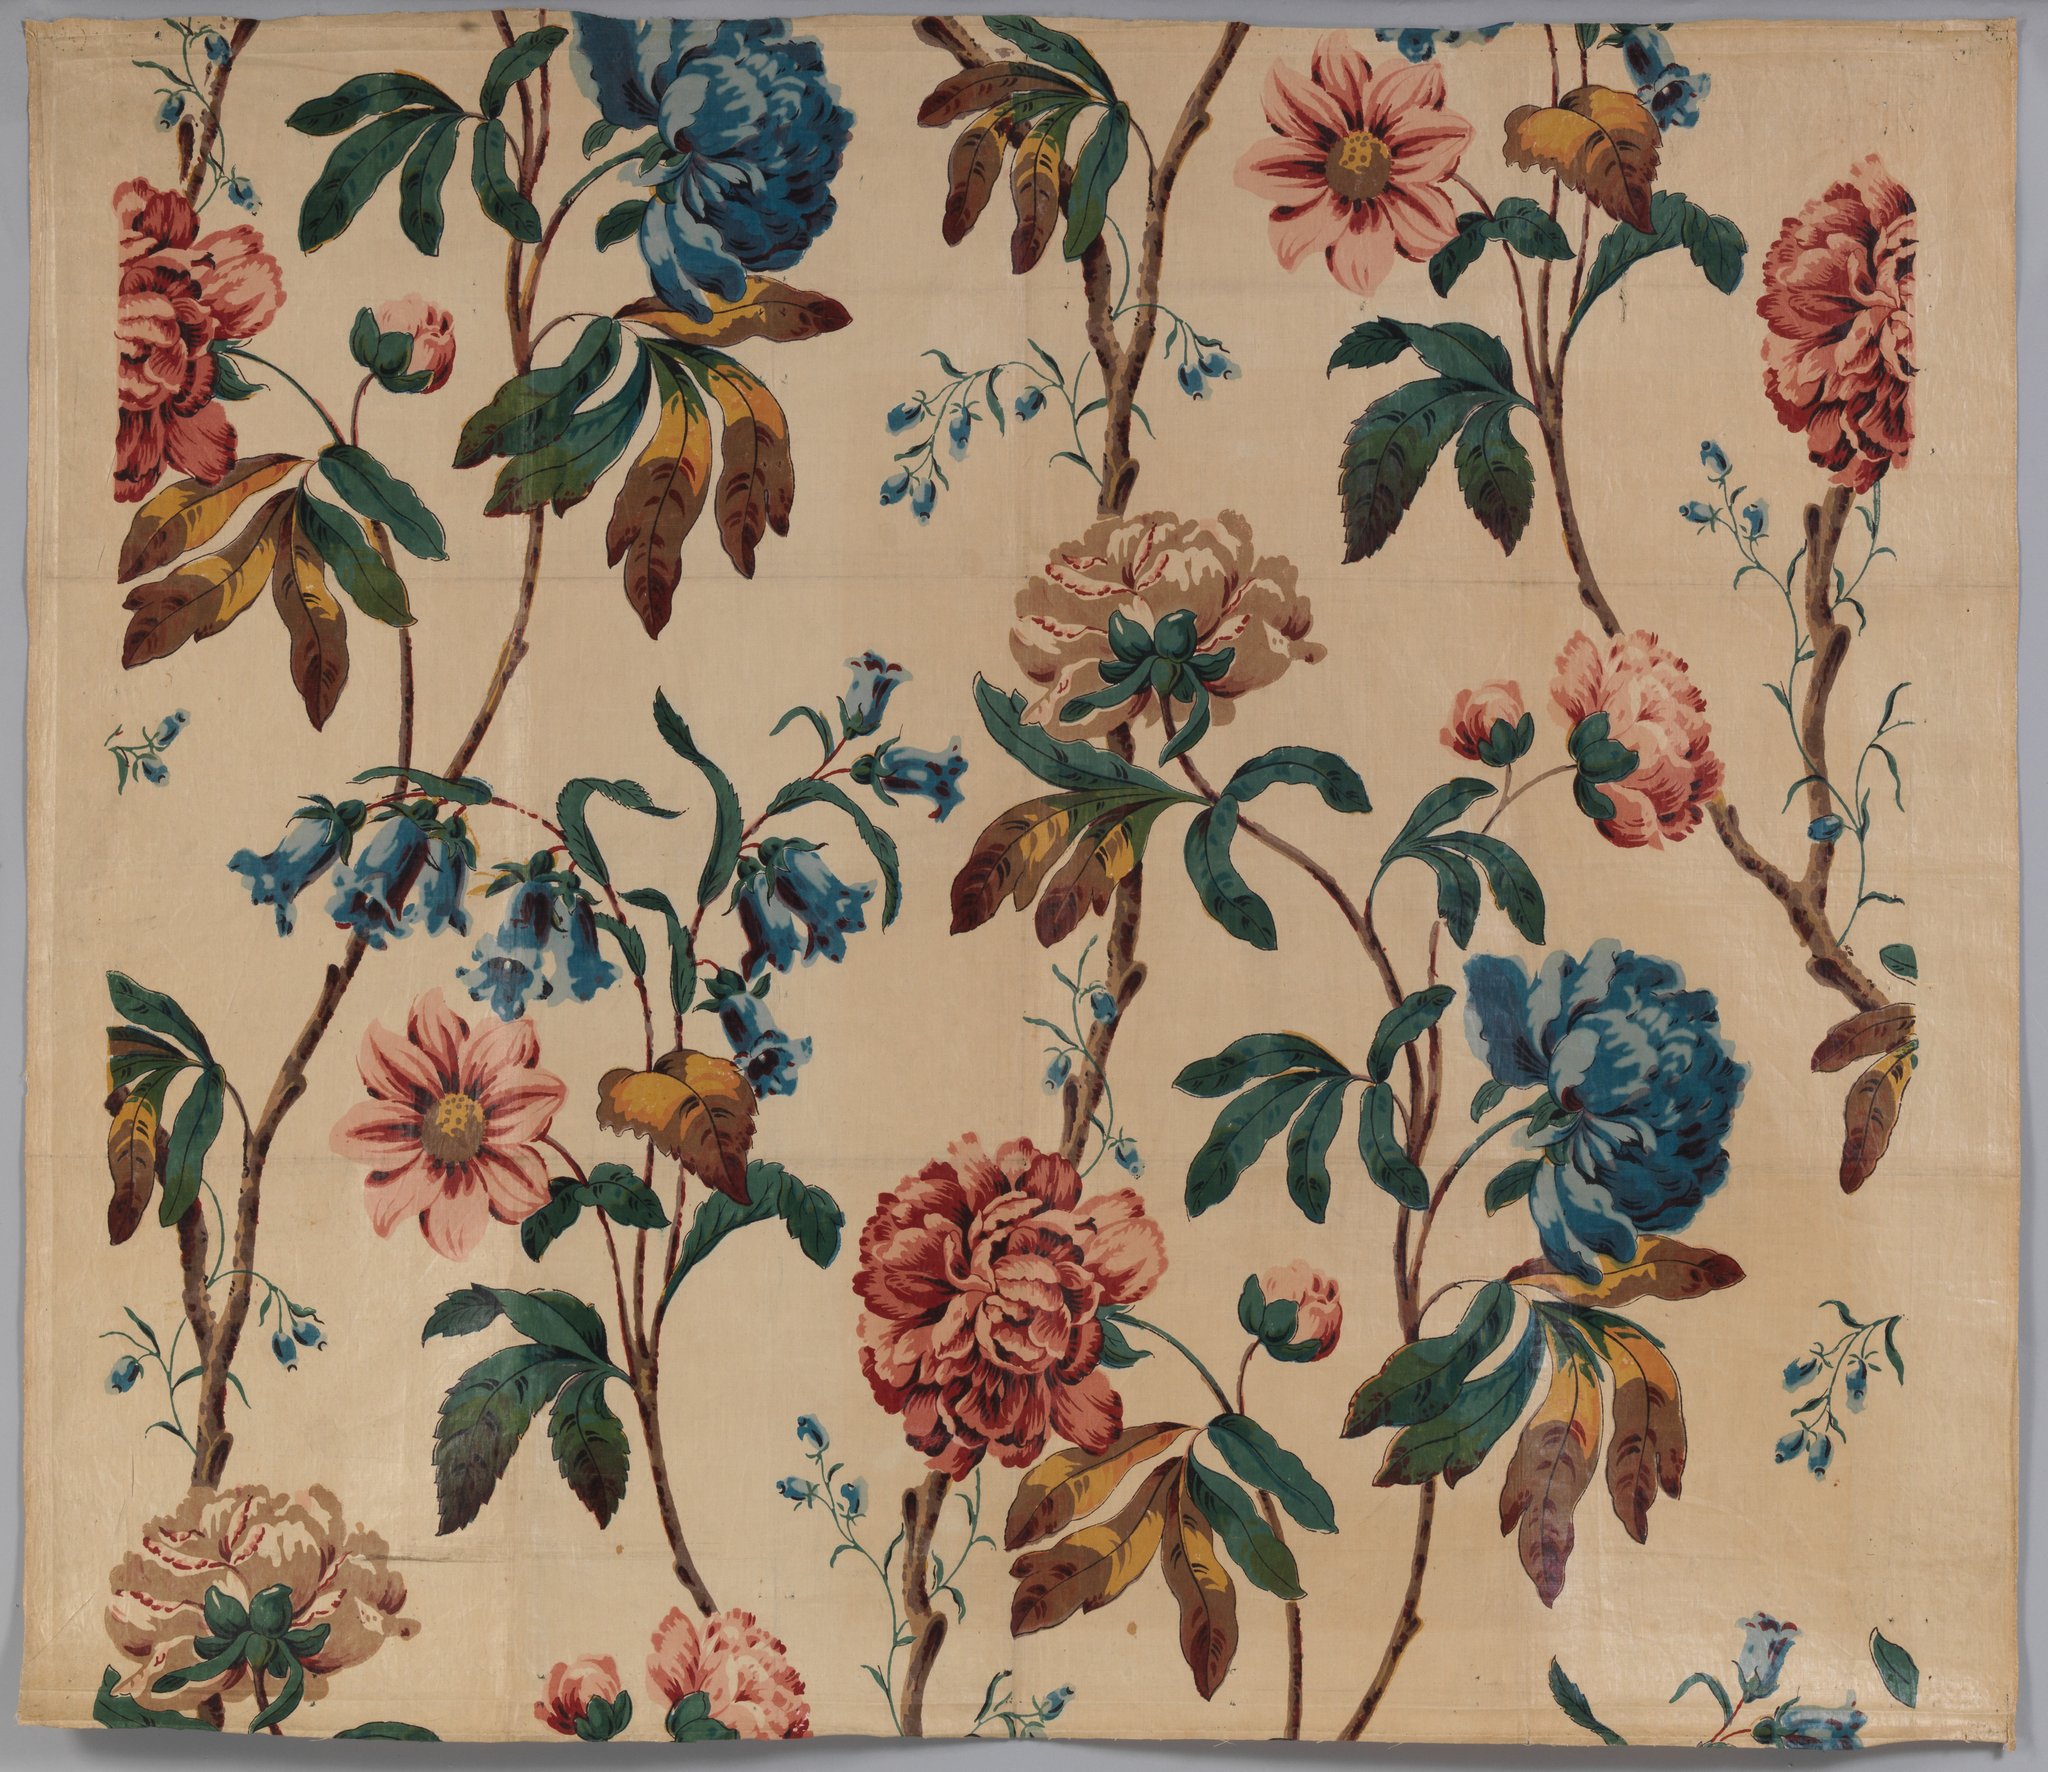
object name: piece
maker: stinton bros.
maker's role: designer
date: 1851-1872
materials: cotton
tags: flowers,leaves